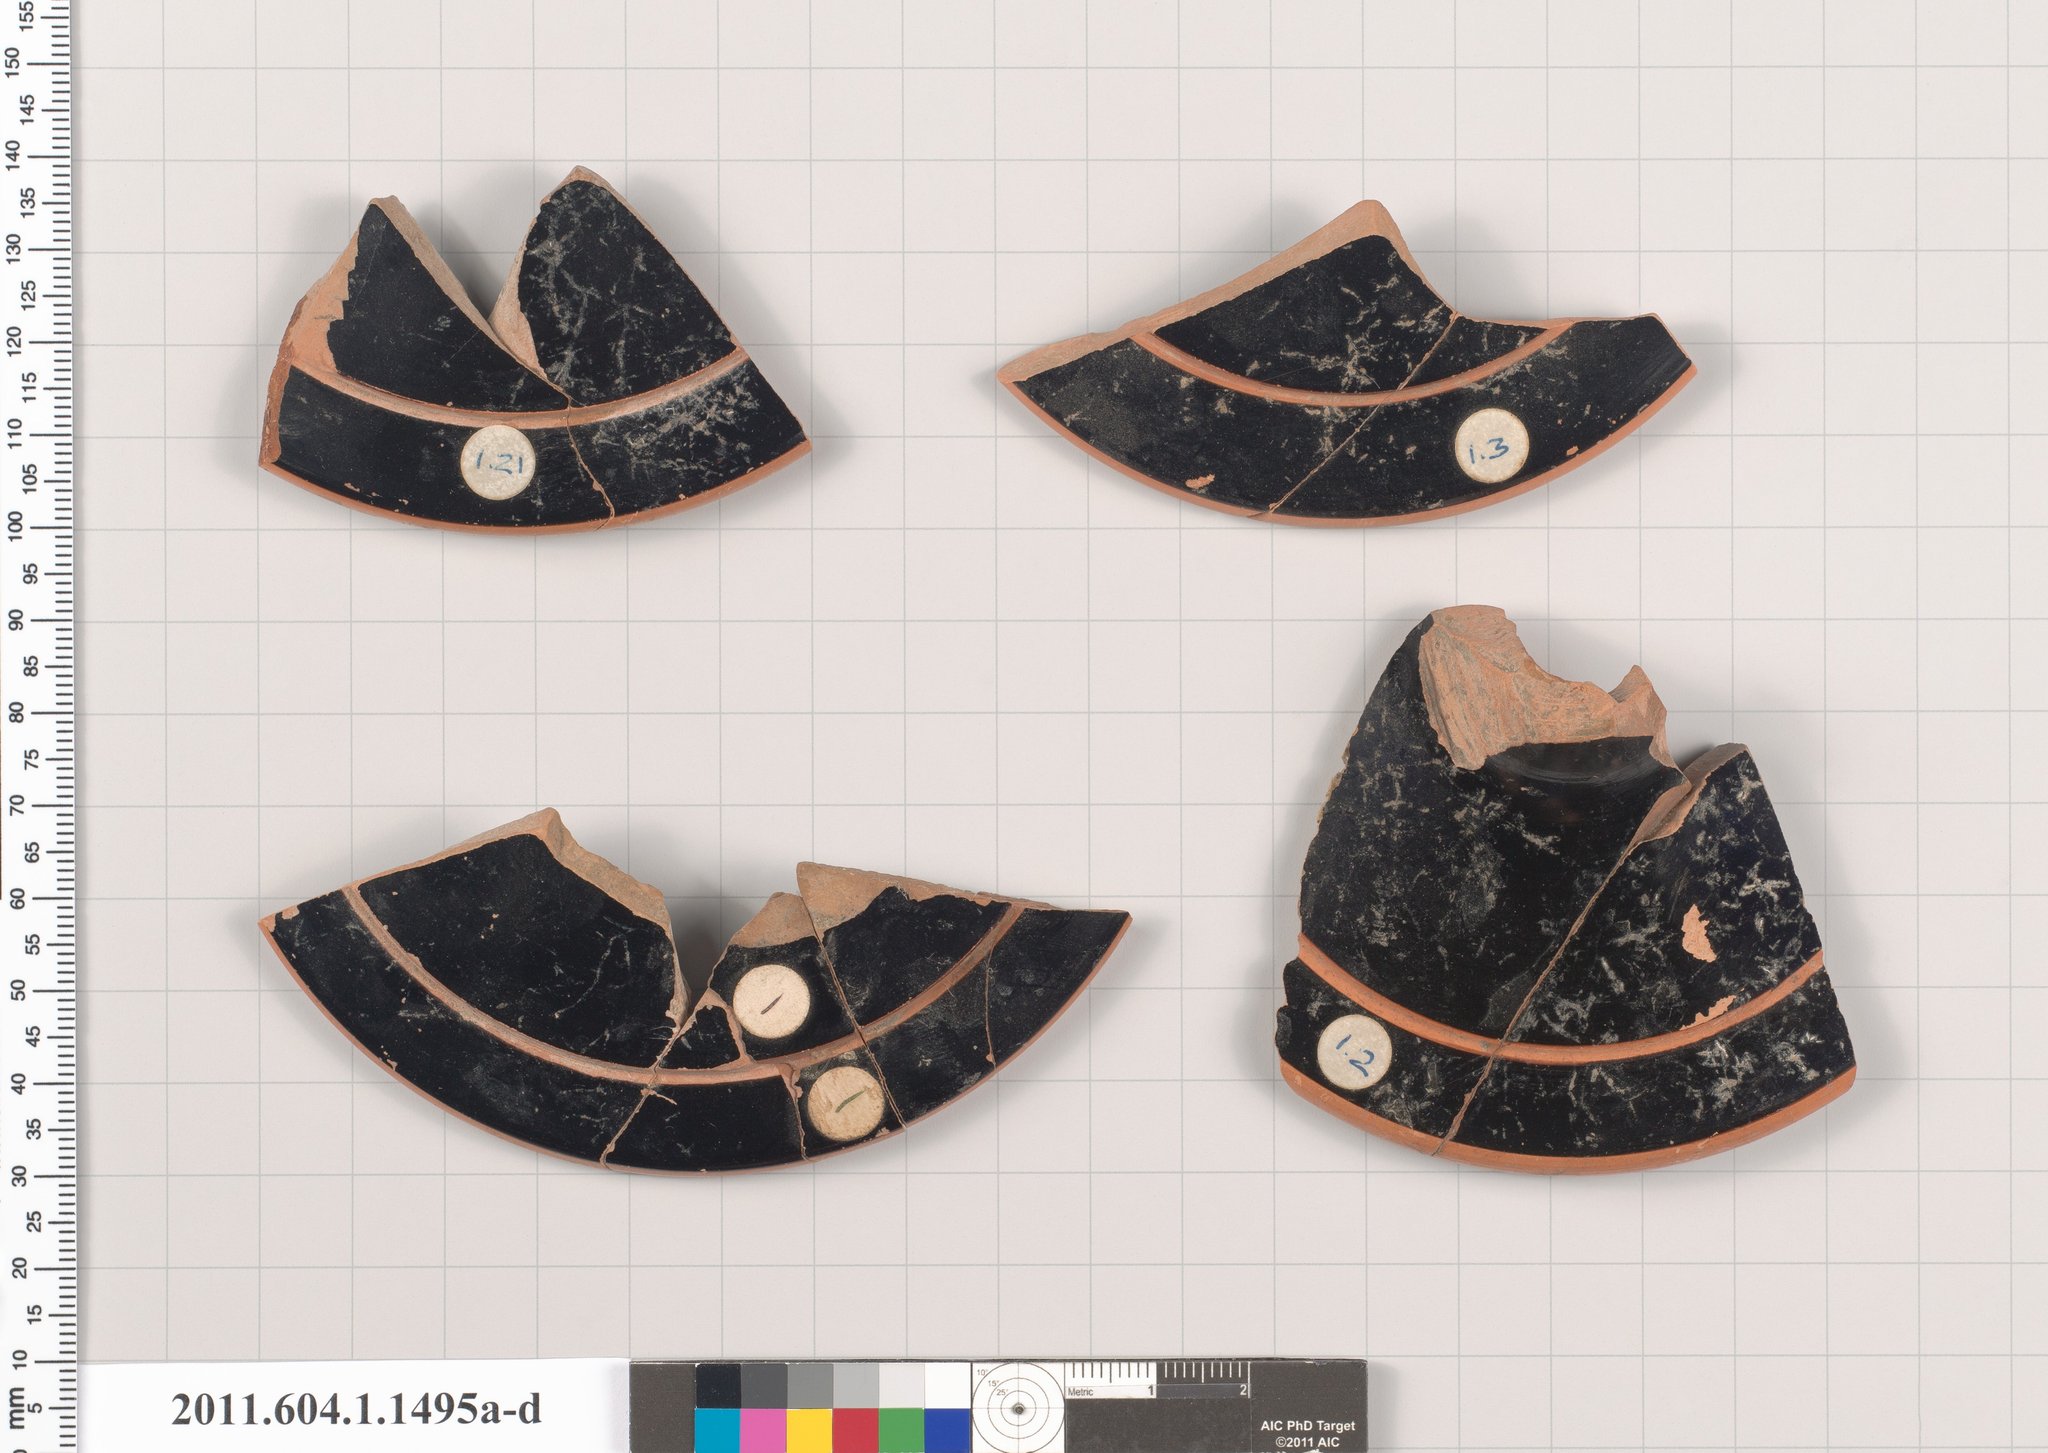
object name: kylix fragment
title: Terracotta fragments of kylikes (drinking cups)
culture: greek, attic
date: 500-401 BCE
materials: terracotta